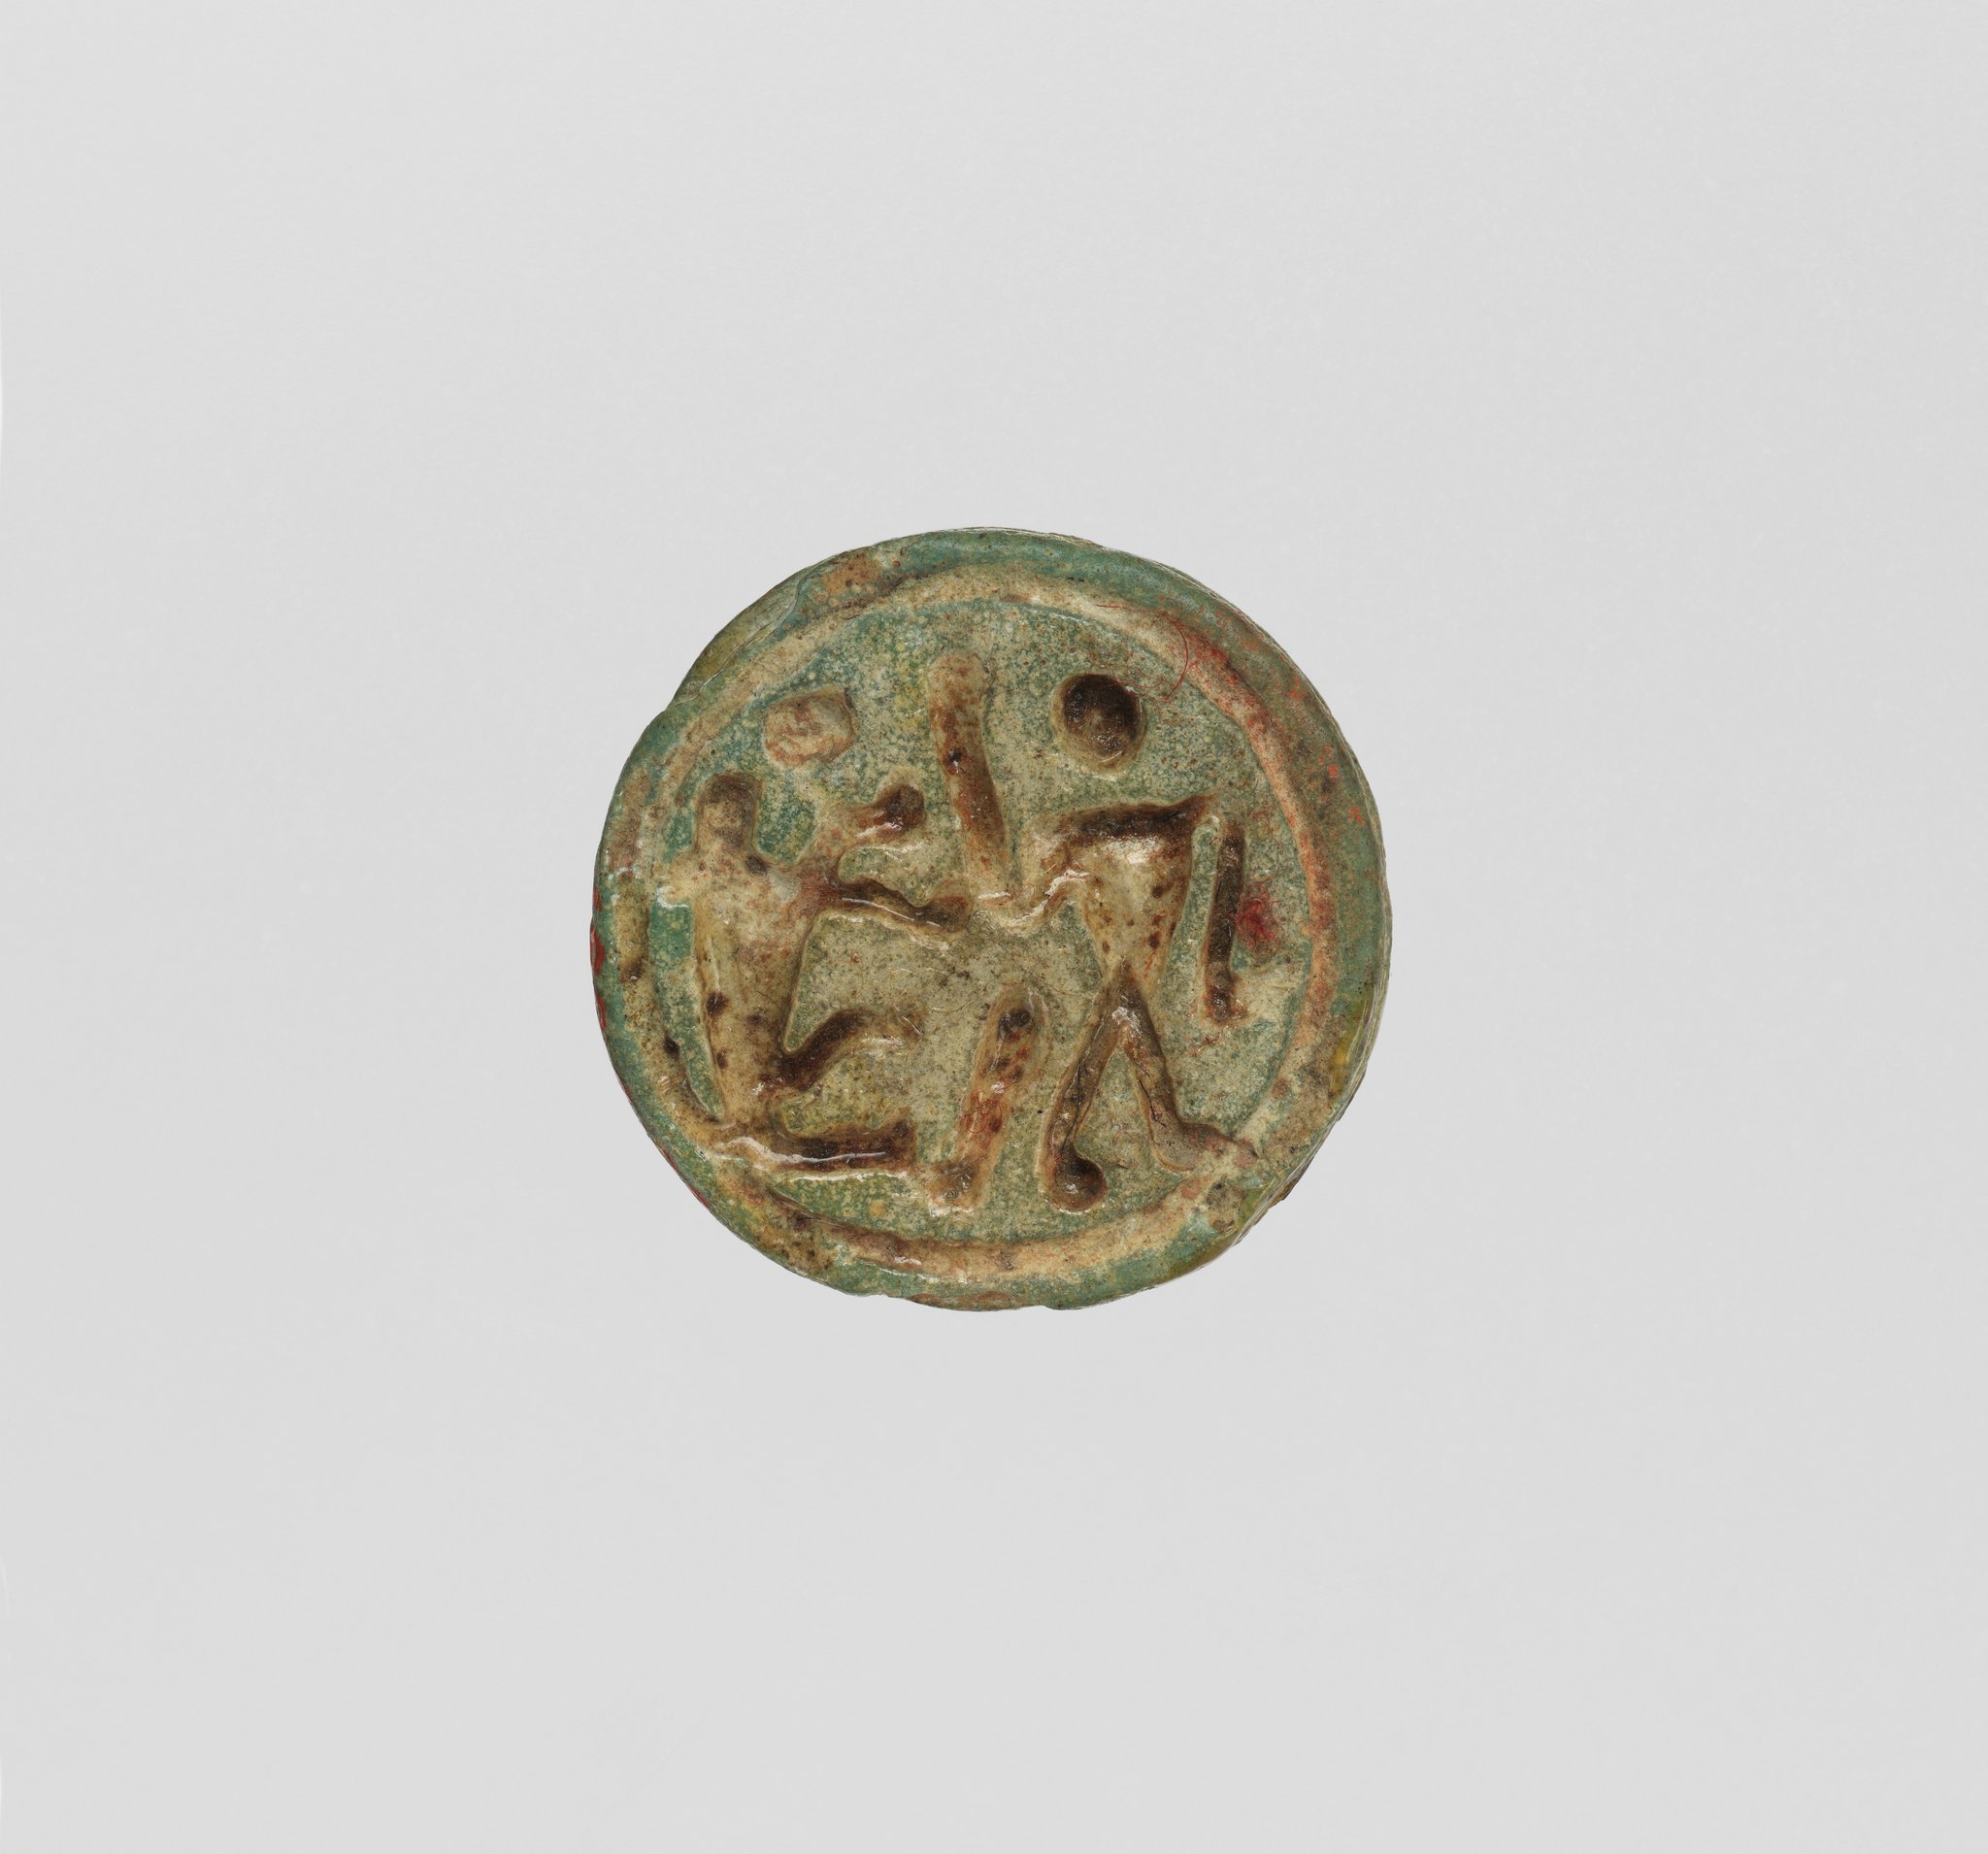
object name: seal, button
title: Button seal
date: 1295-1070 BCE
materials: faience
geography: egypt